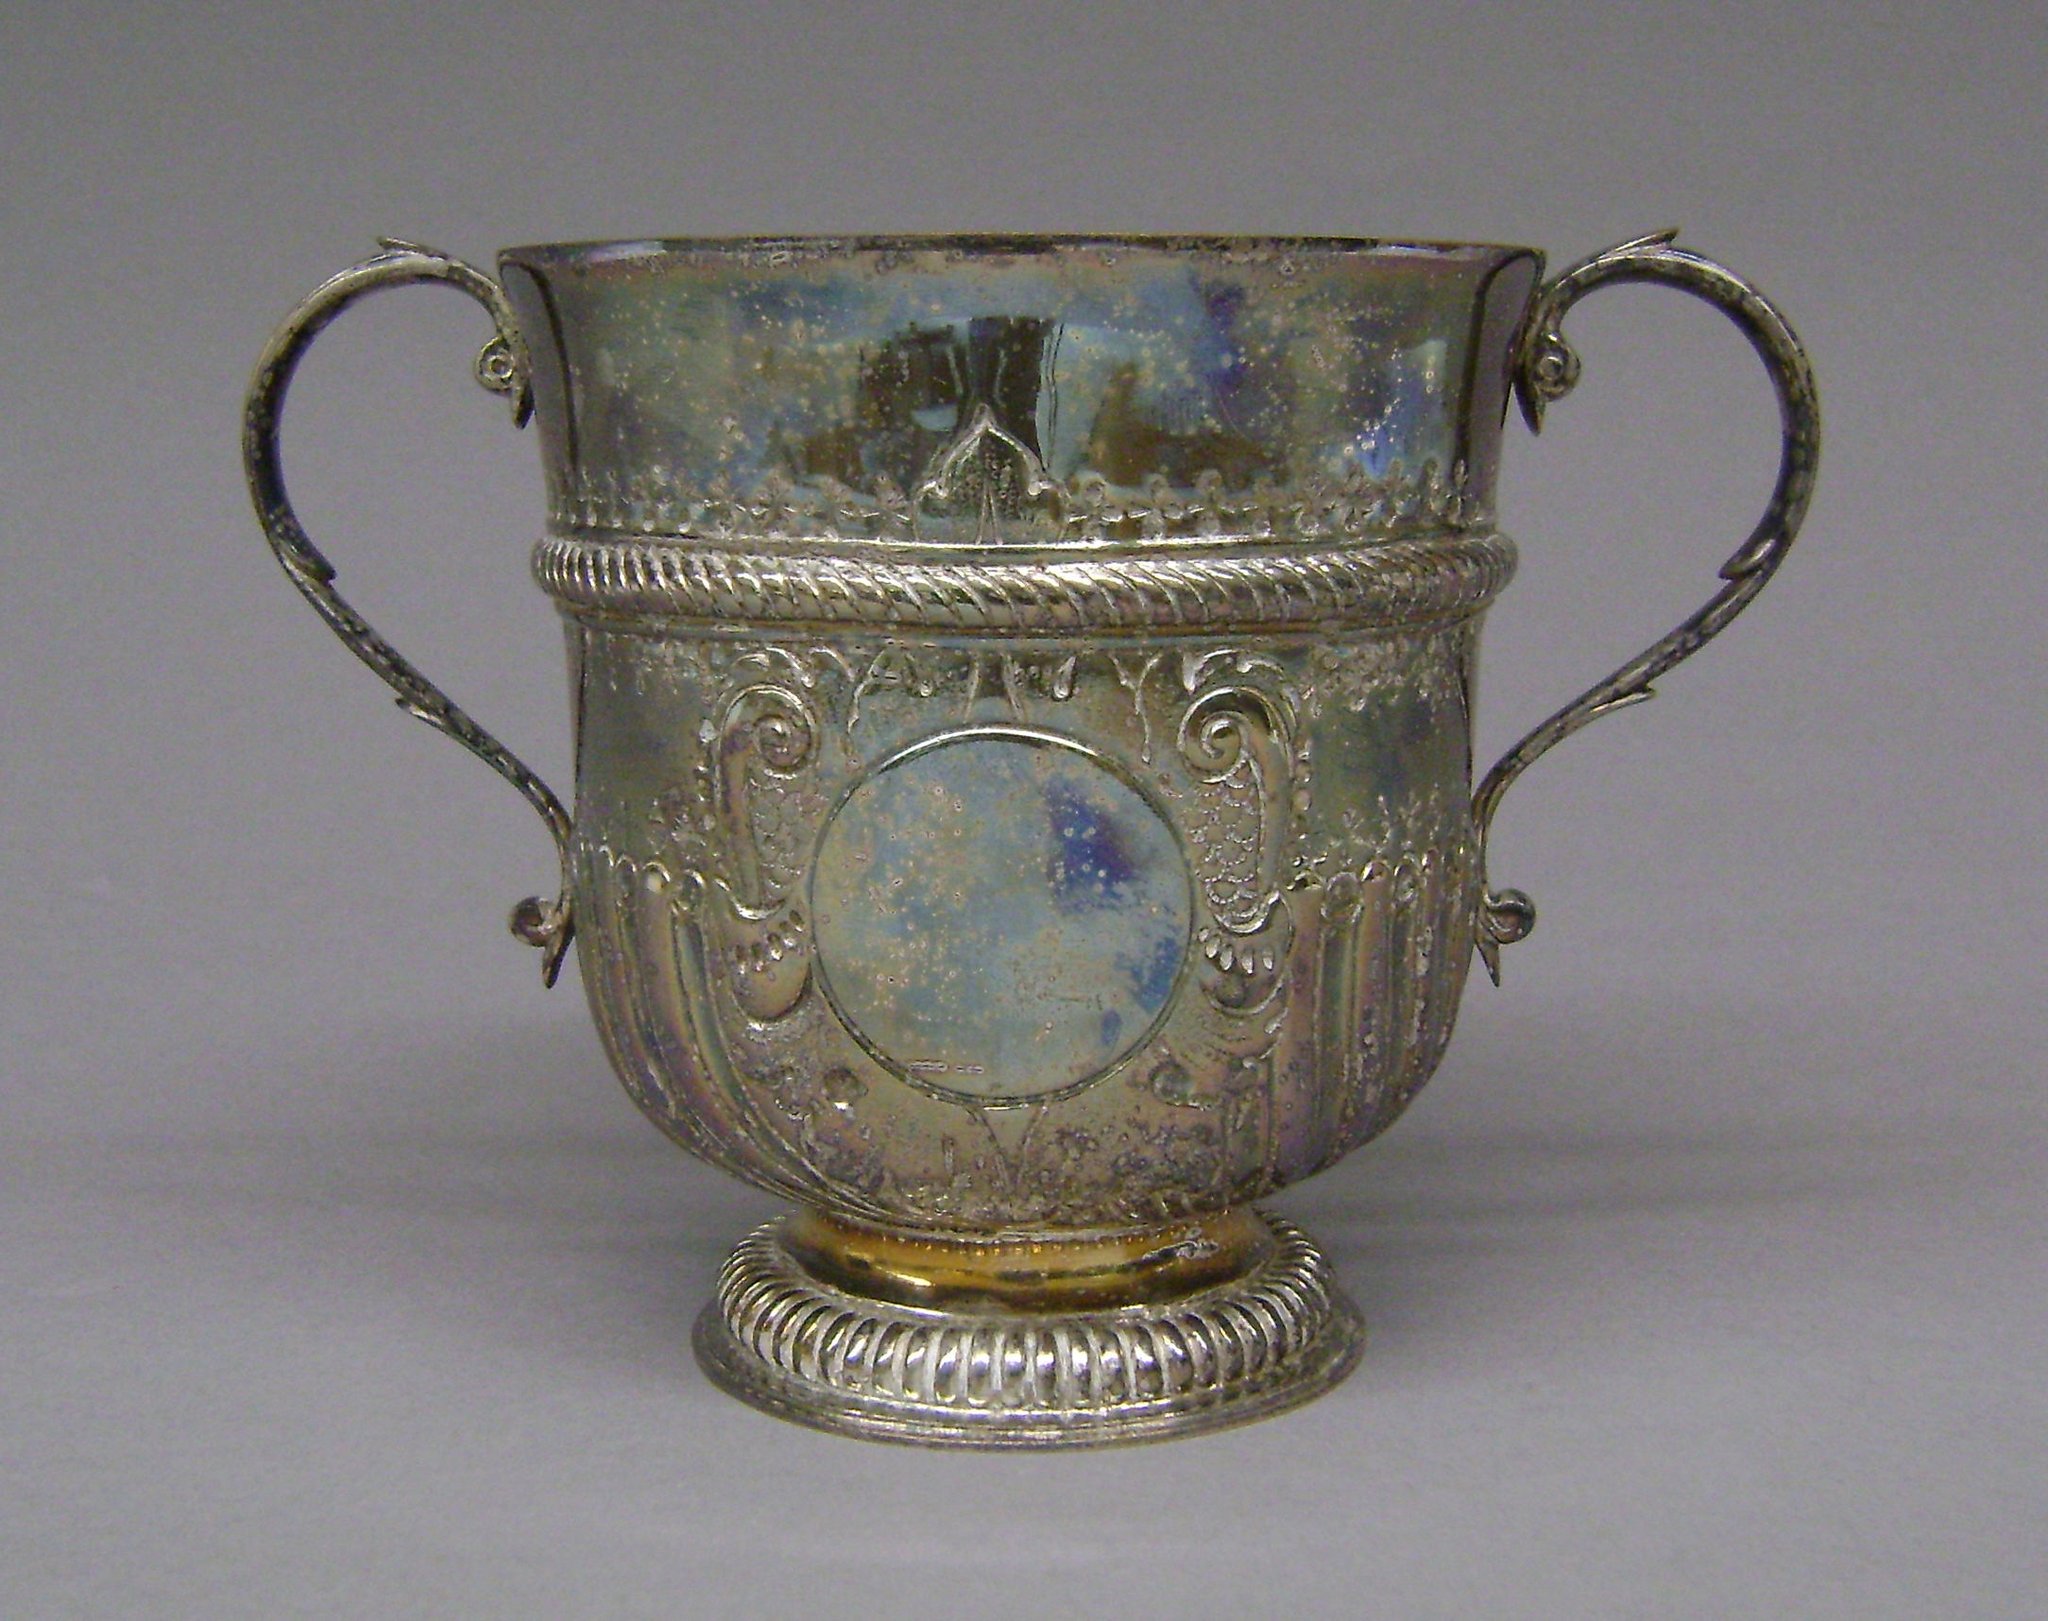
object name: cup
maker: franchi and son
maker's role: manufacturer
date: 1801-1900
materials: metal, silver